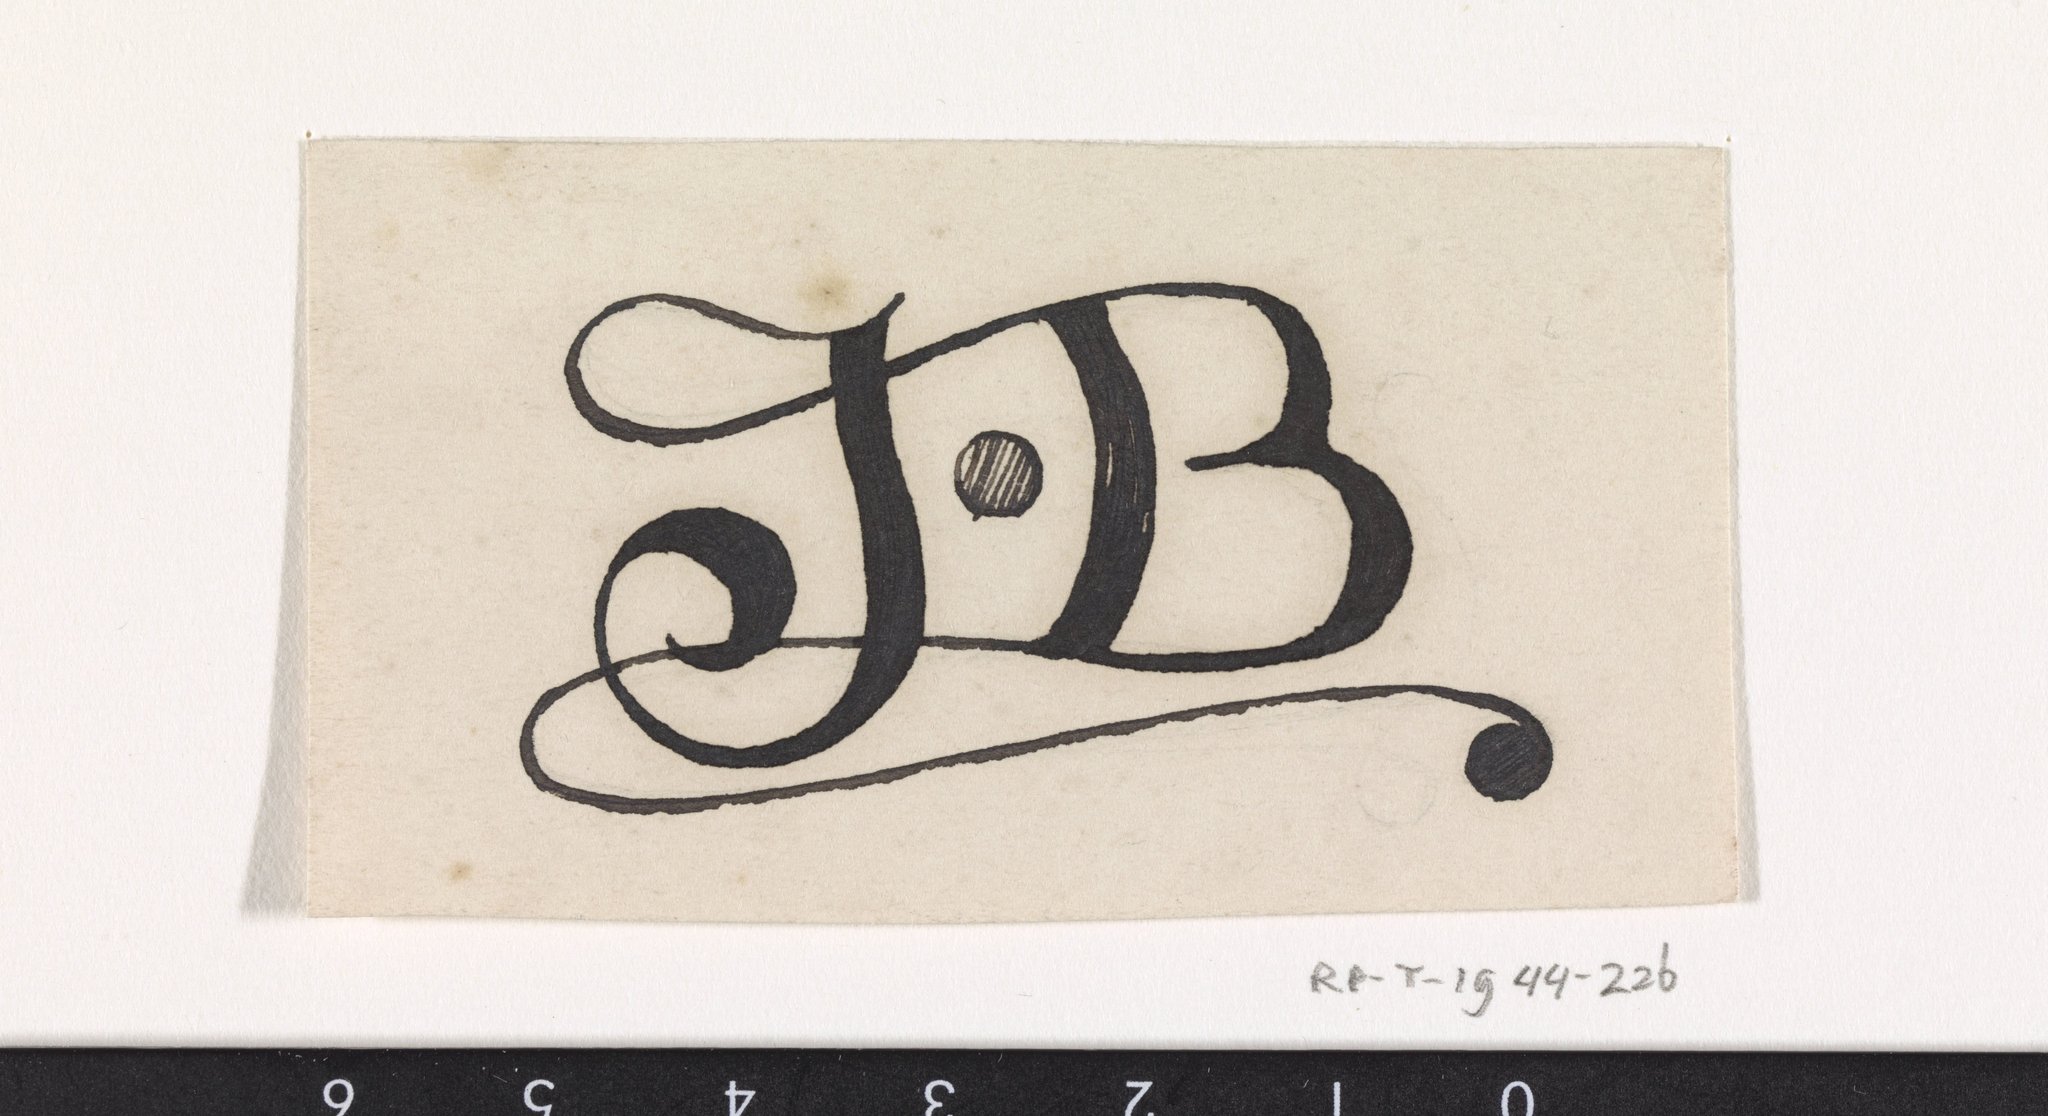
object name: drawing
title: Ontwerp voor een monogram met de letters J en B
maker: antoon derkinderen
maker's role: draughtsman, painter, print maker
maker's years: 1859-1925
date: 1869-1925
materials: ink, paper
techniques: pen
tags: letter combinations such as letterword, anagram, letter square, monogram, etc.